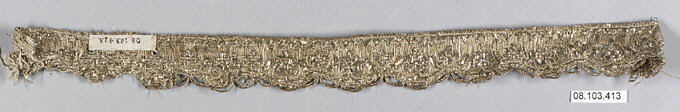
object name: galloon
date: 1701-1800